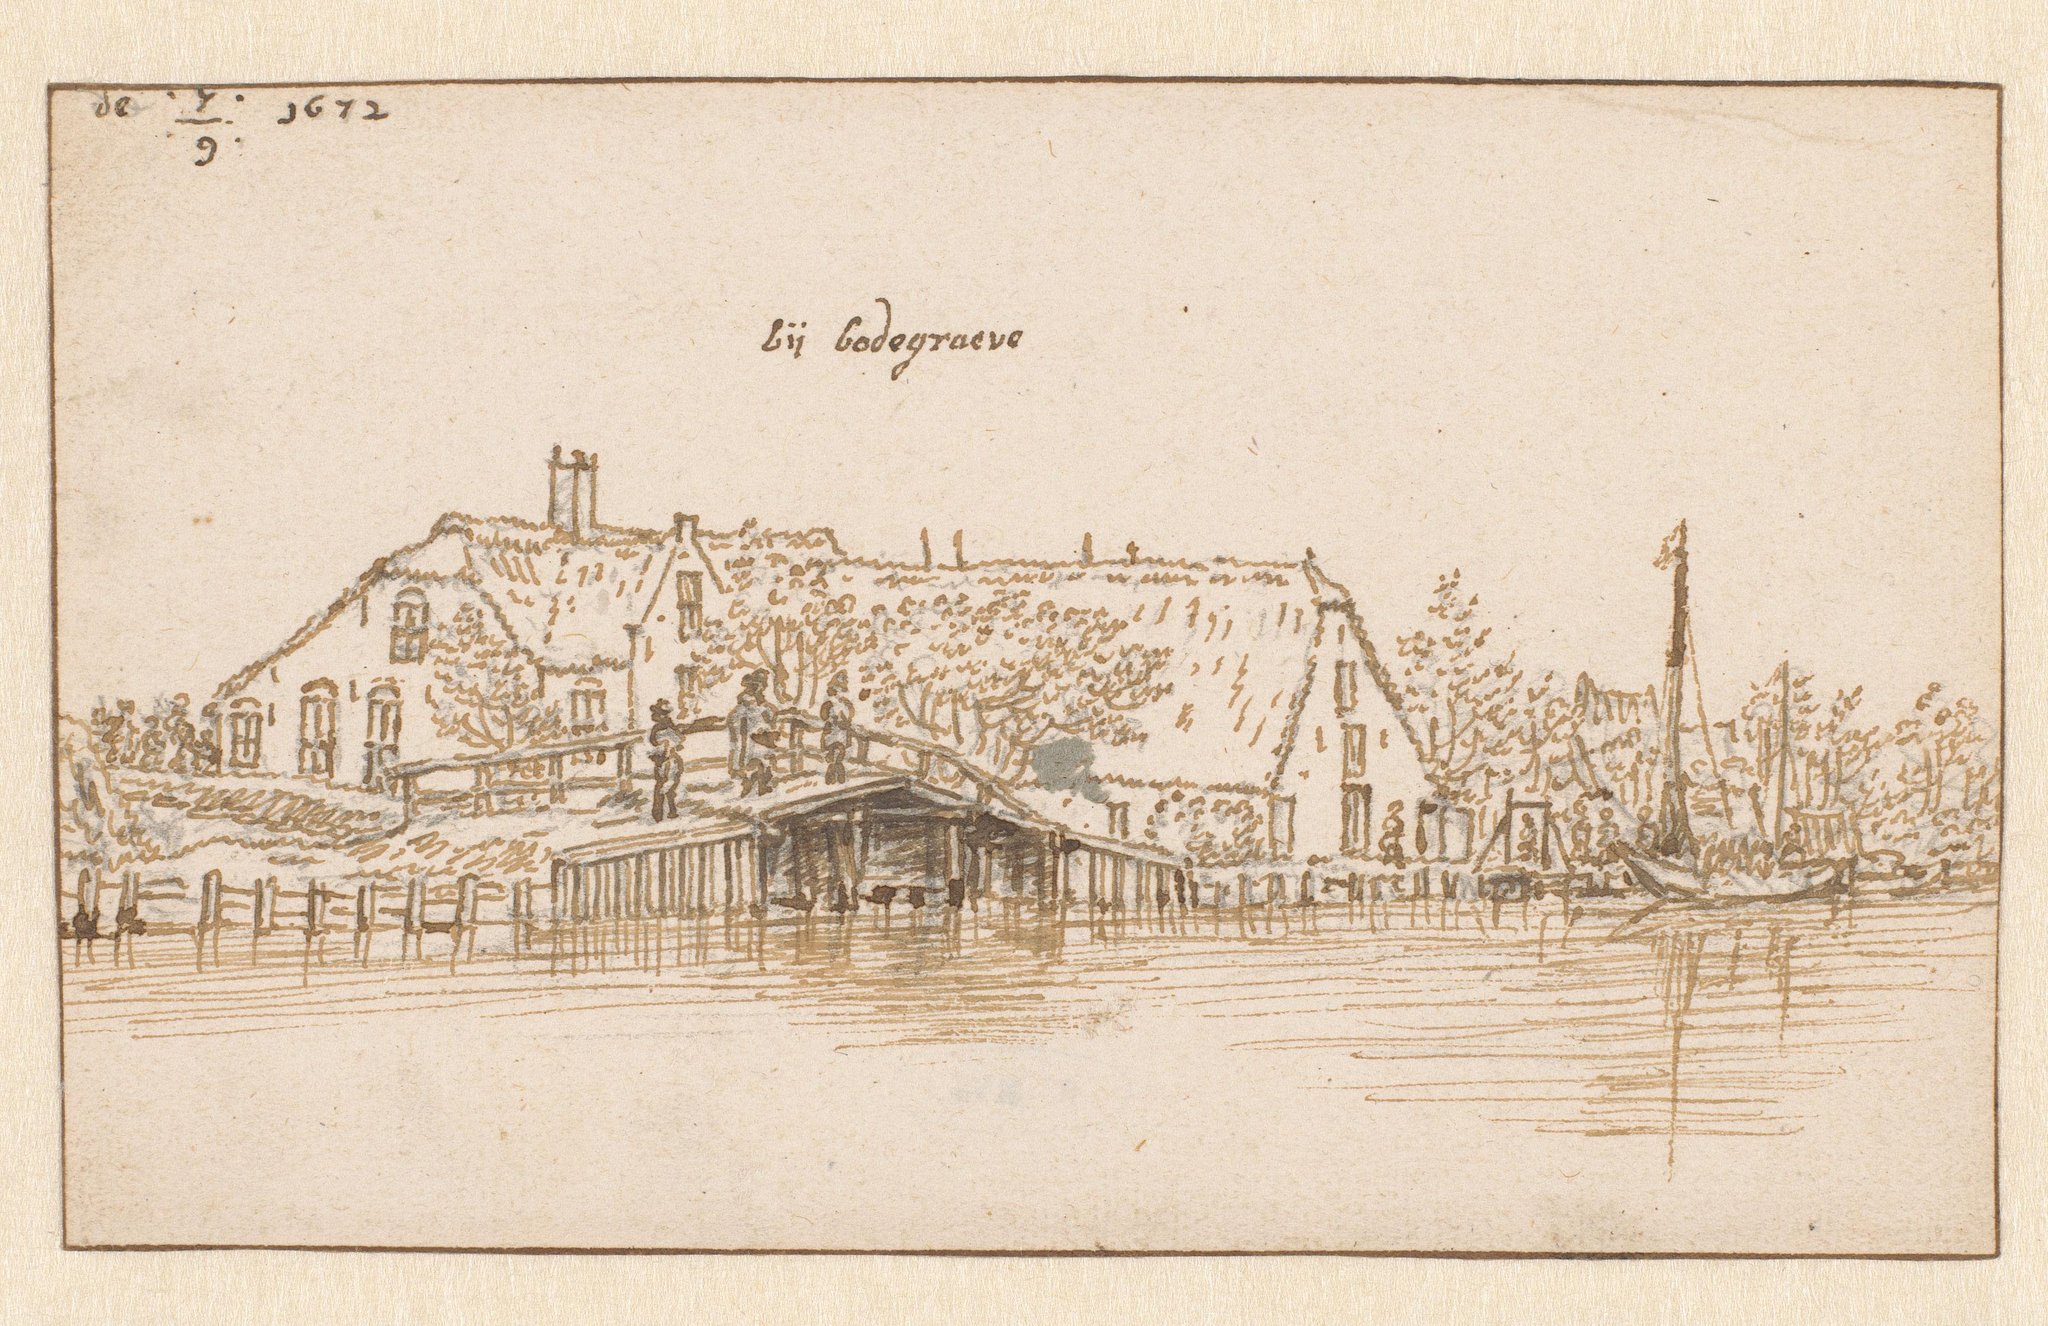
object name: drawing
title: View of the Riverbank at Bodegraven, Zuid-Holland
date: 1672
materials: ink, paper, pencil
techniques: pen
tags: river bank, bodegraven